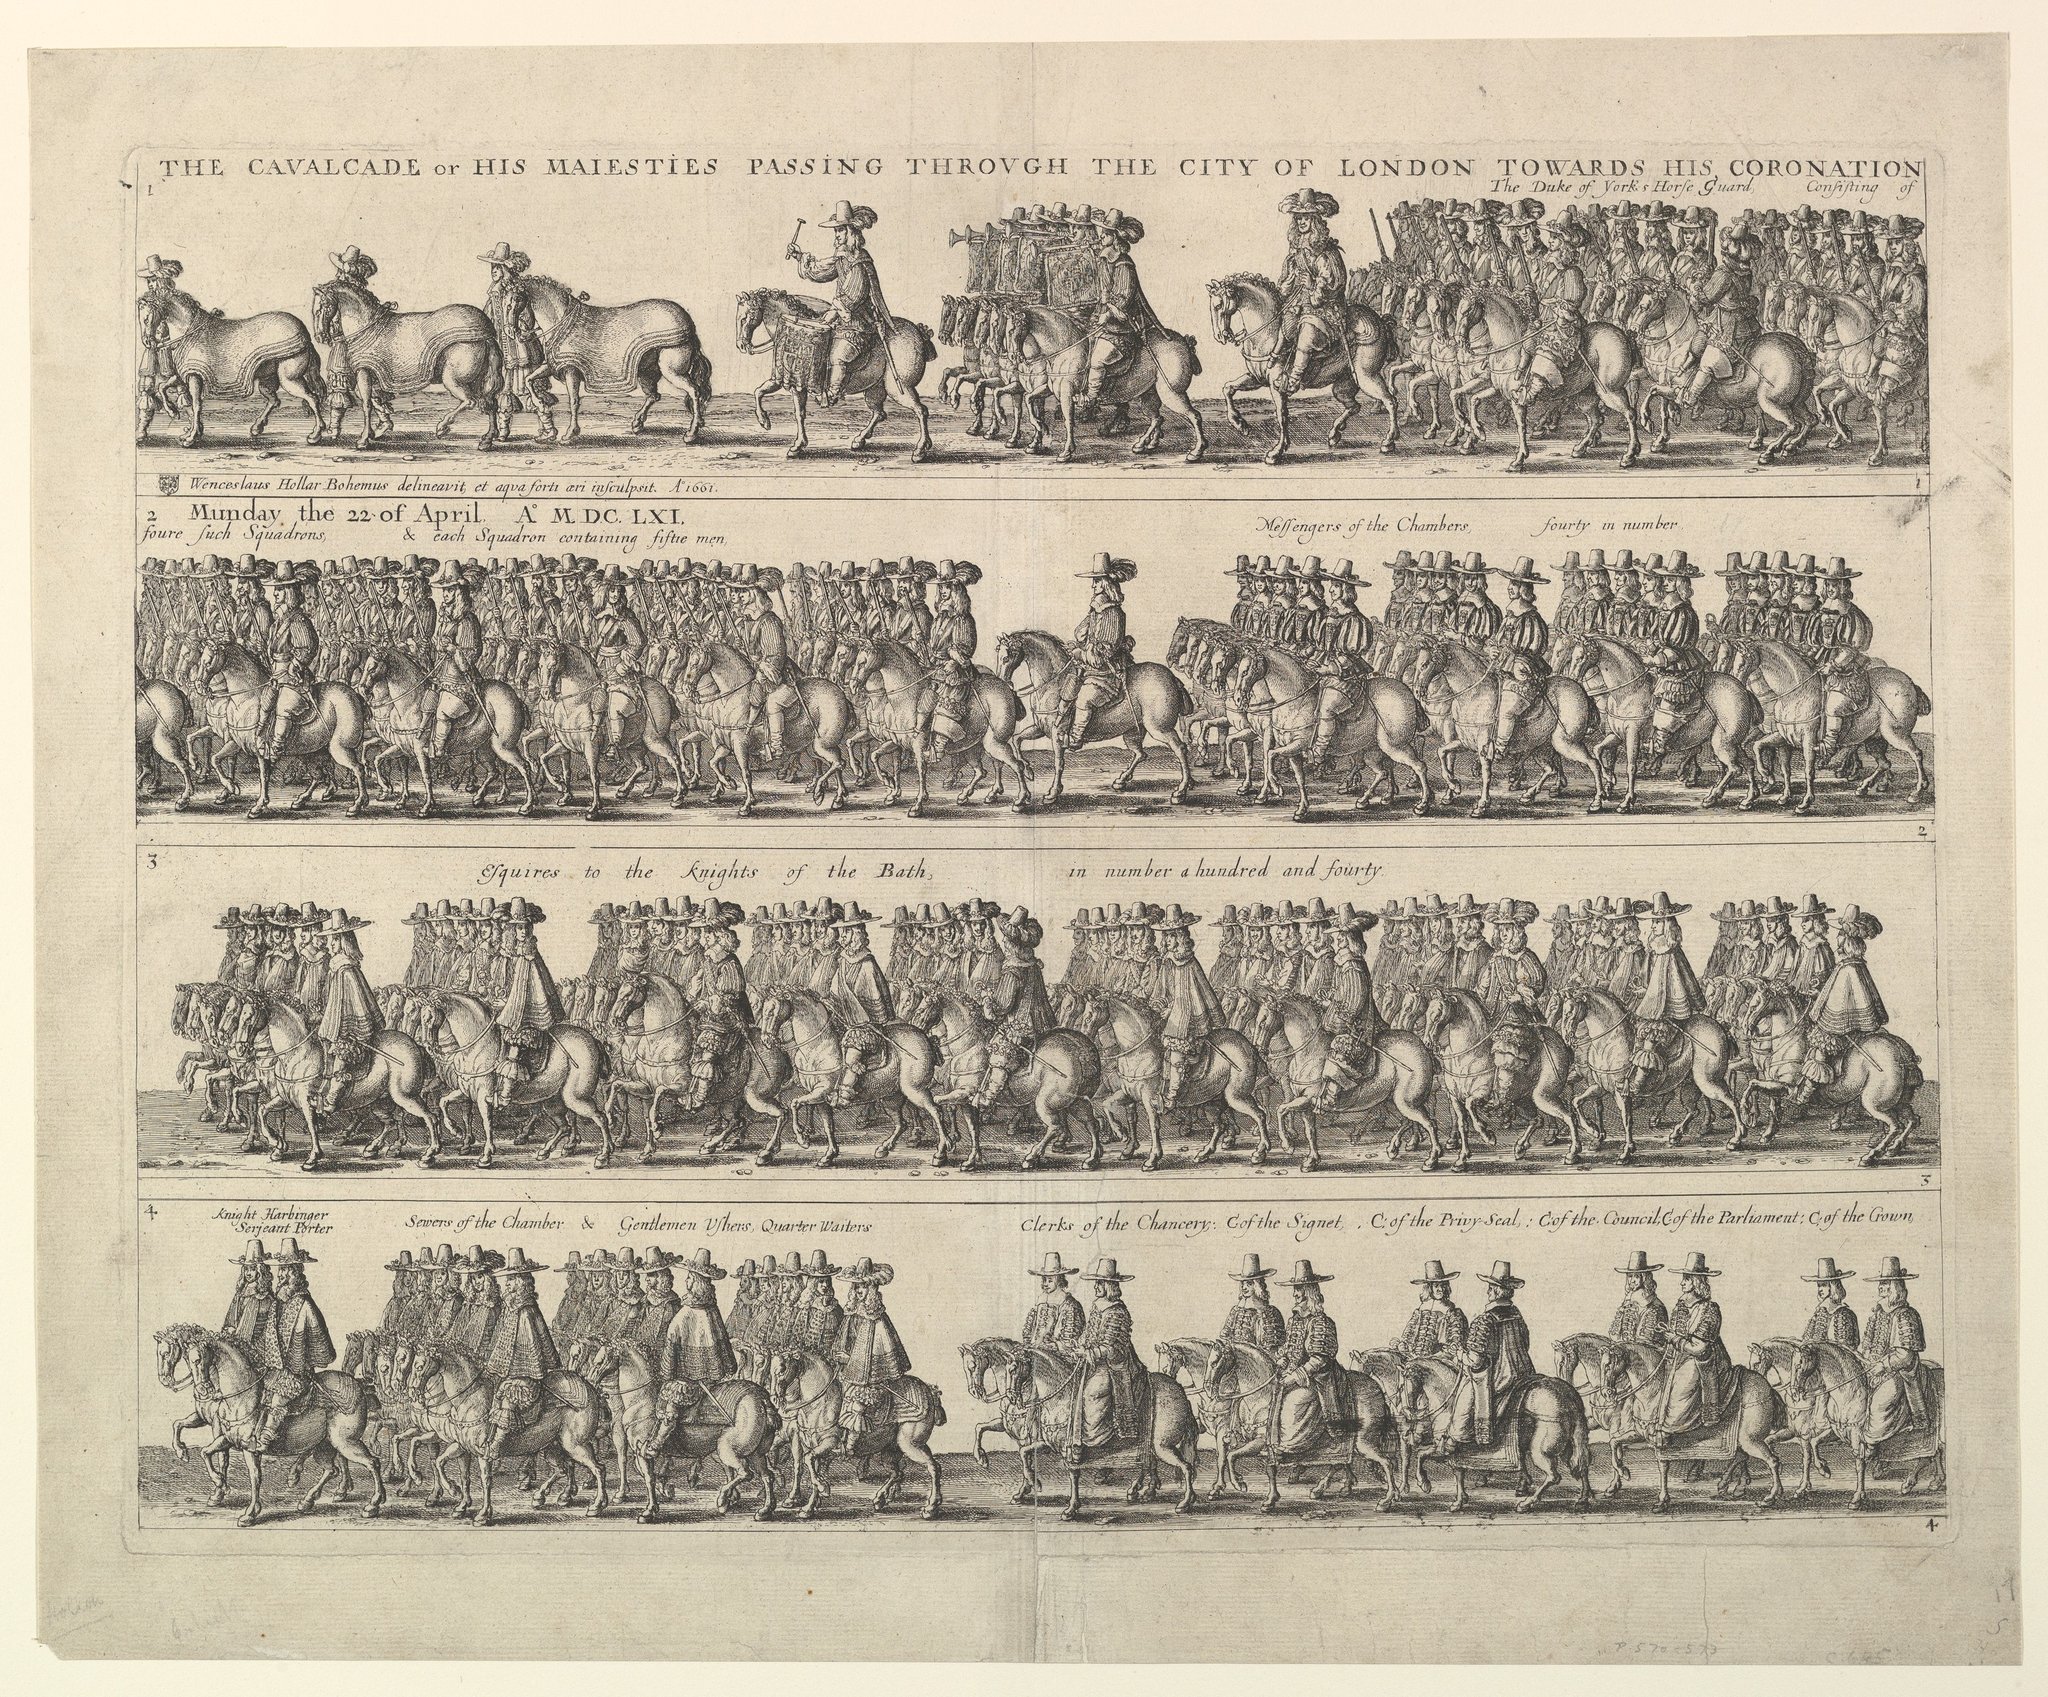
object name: print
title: Coronation Procession of Charles II Through London (from John Ogilby's "The Entertainment of...Charles II," London, 1662)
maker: wenceslaus hollar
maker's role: artist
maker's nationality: bohemian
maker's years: 1607-1677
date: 1662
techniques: etching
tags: soldiers,men,horses